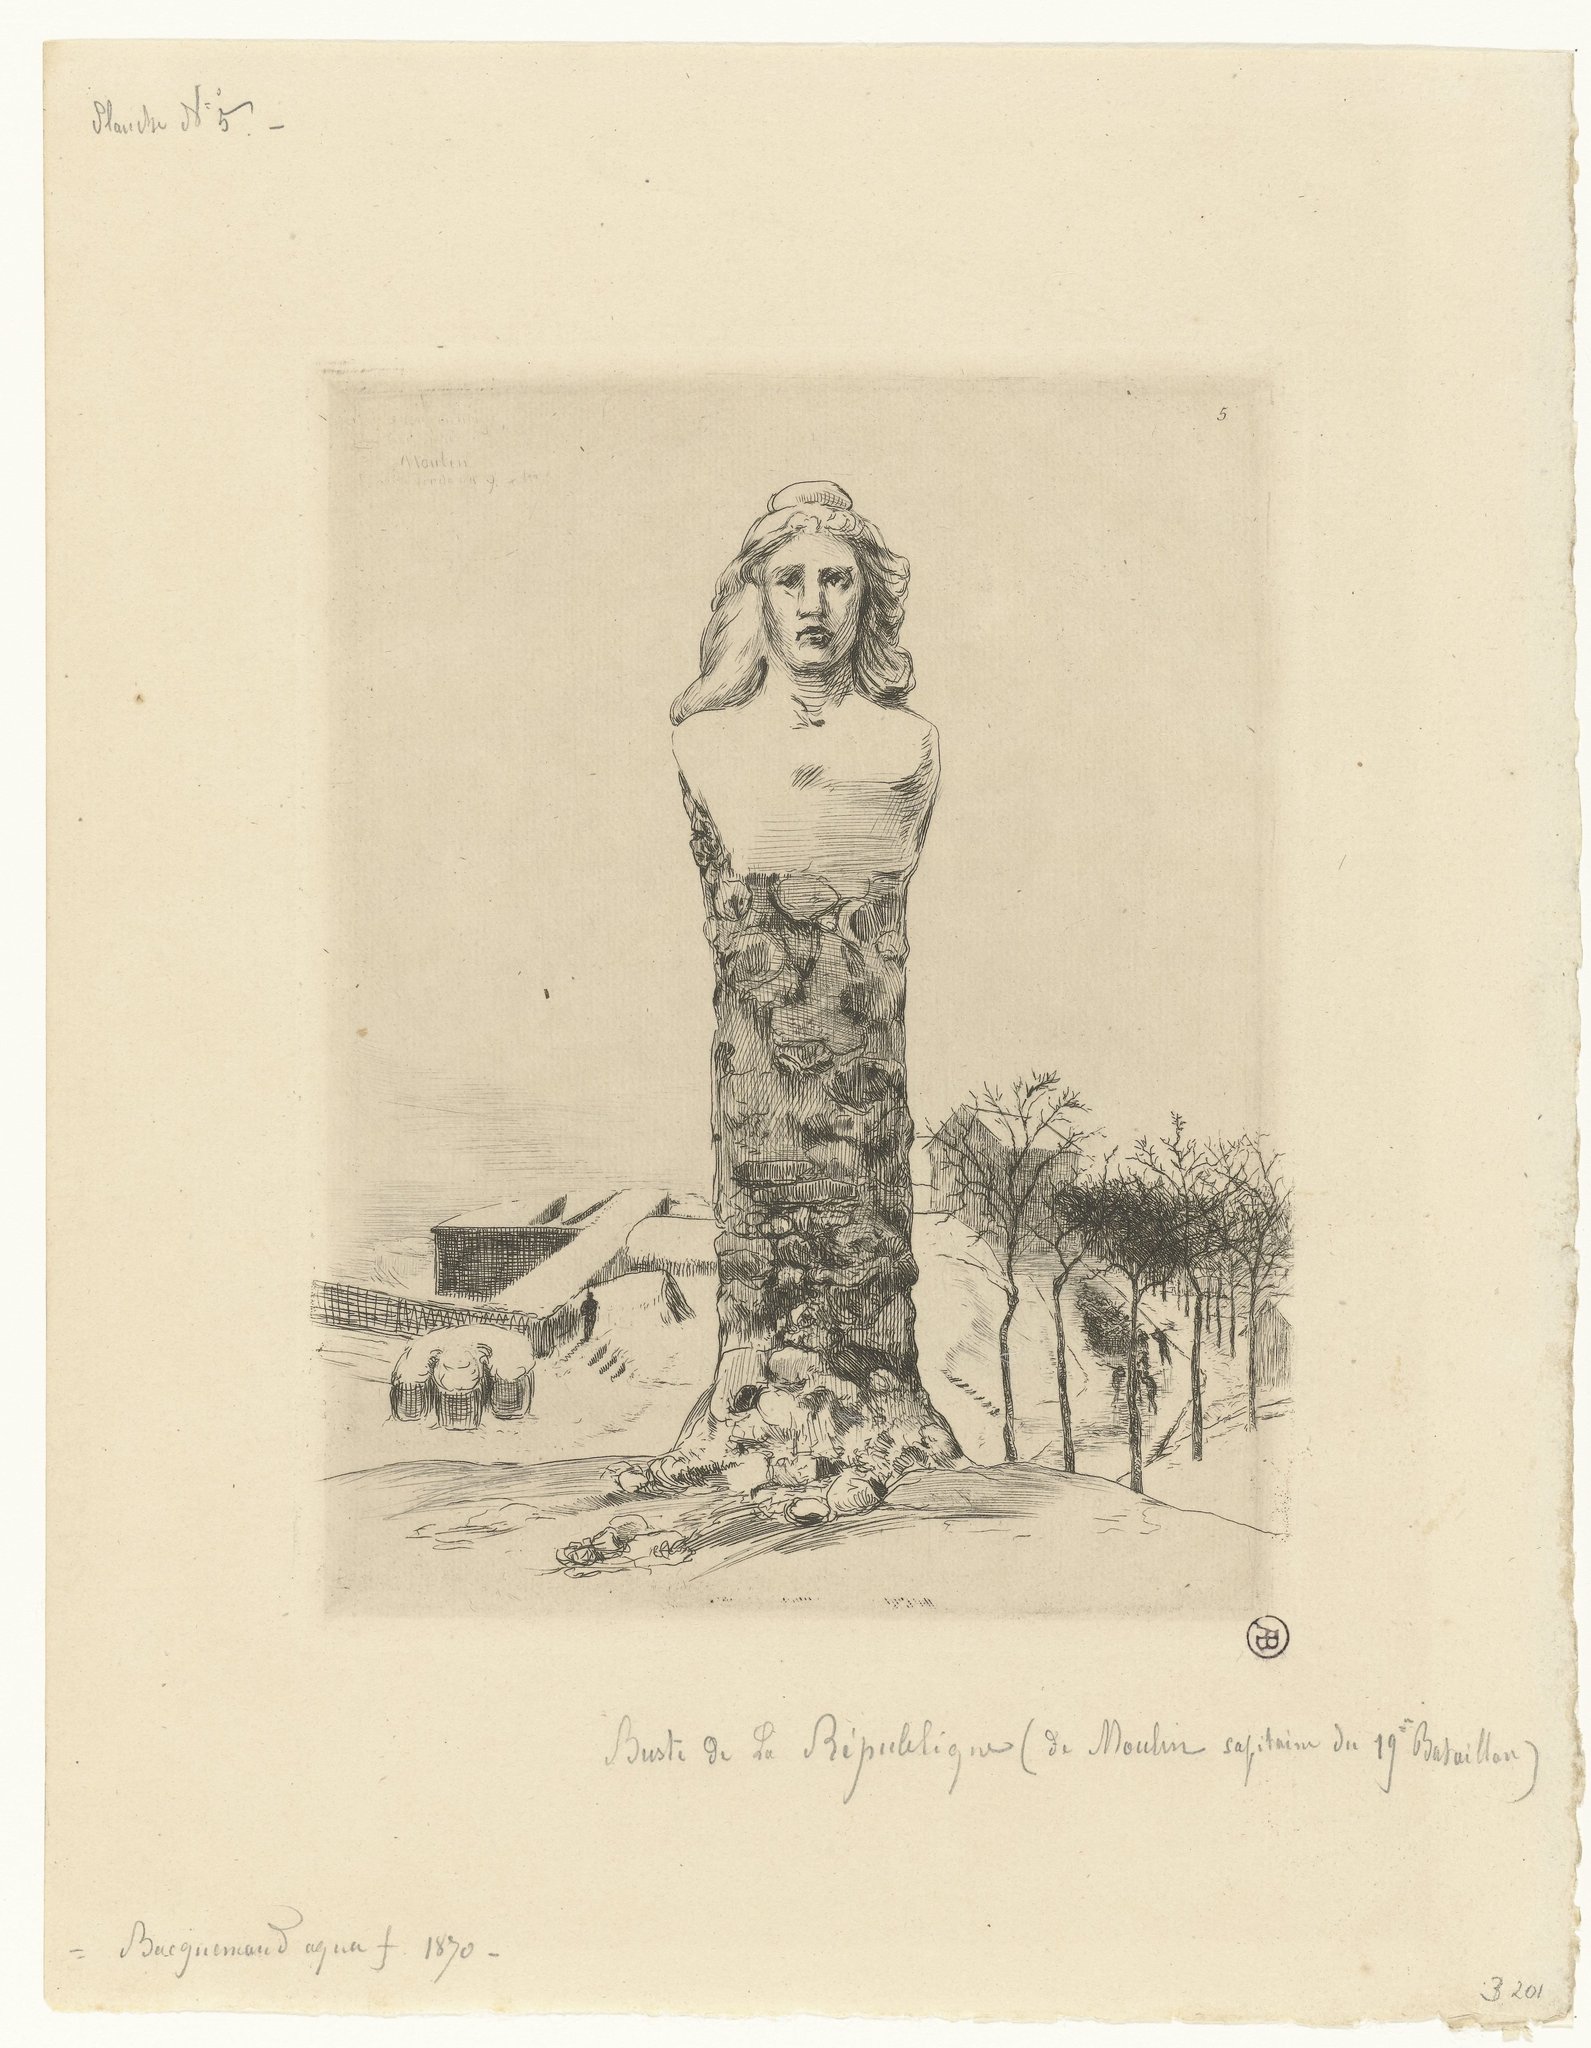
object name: print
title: Siège de Paris en 1870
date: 1870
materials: paper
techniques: etching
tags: paris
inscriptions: collector's mark: Lugt 76, collector's mark: Lugt 2228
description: Ets gebruikt voor: Siège de Paris en 1870, Roquette (uitgever), 1874. Verschenen in een oplage van honderd exemplaren maar het is onduidelijk welke staat gebruikt werd voor de publicatie (Beraldi 1885, nr. 201).